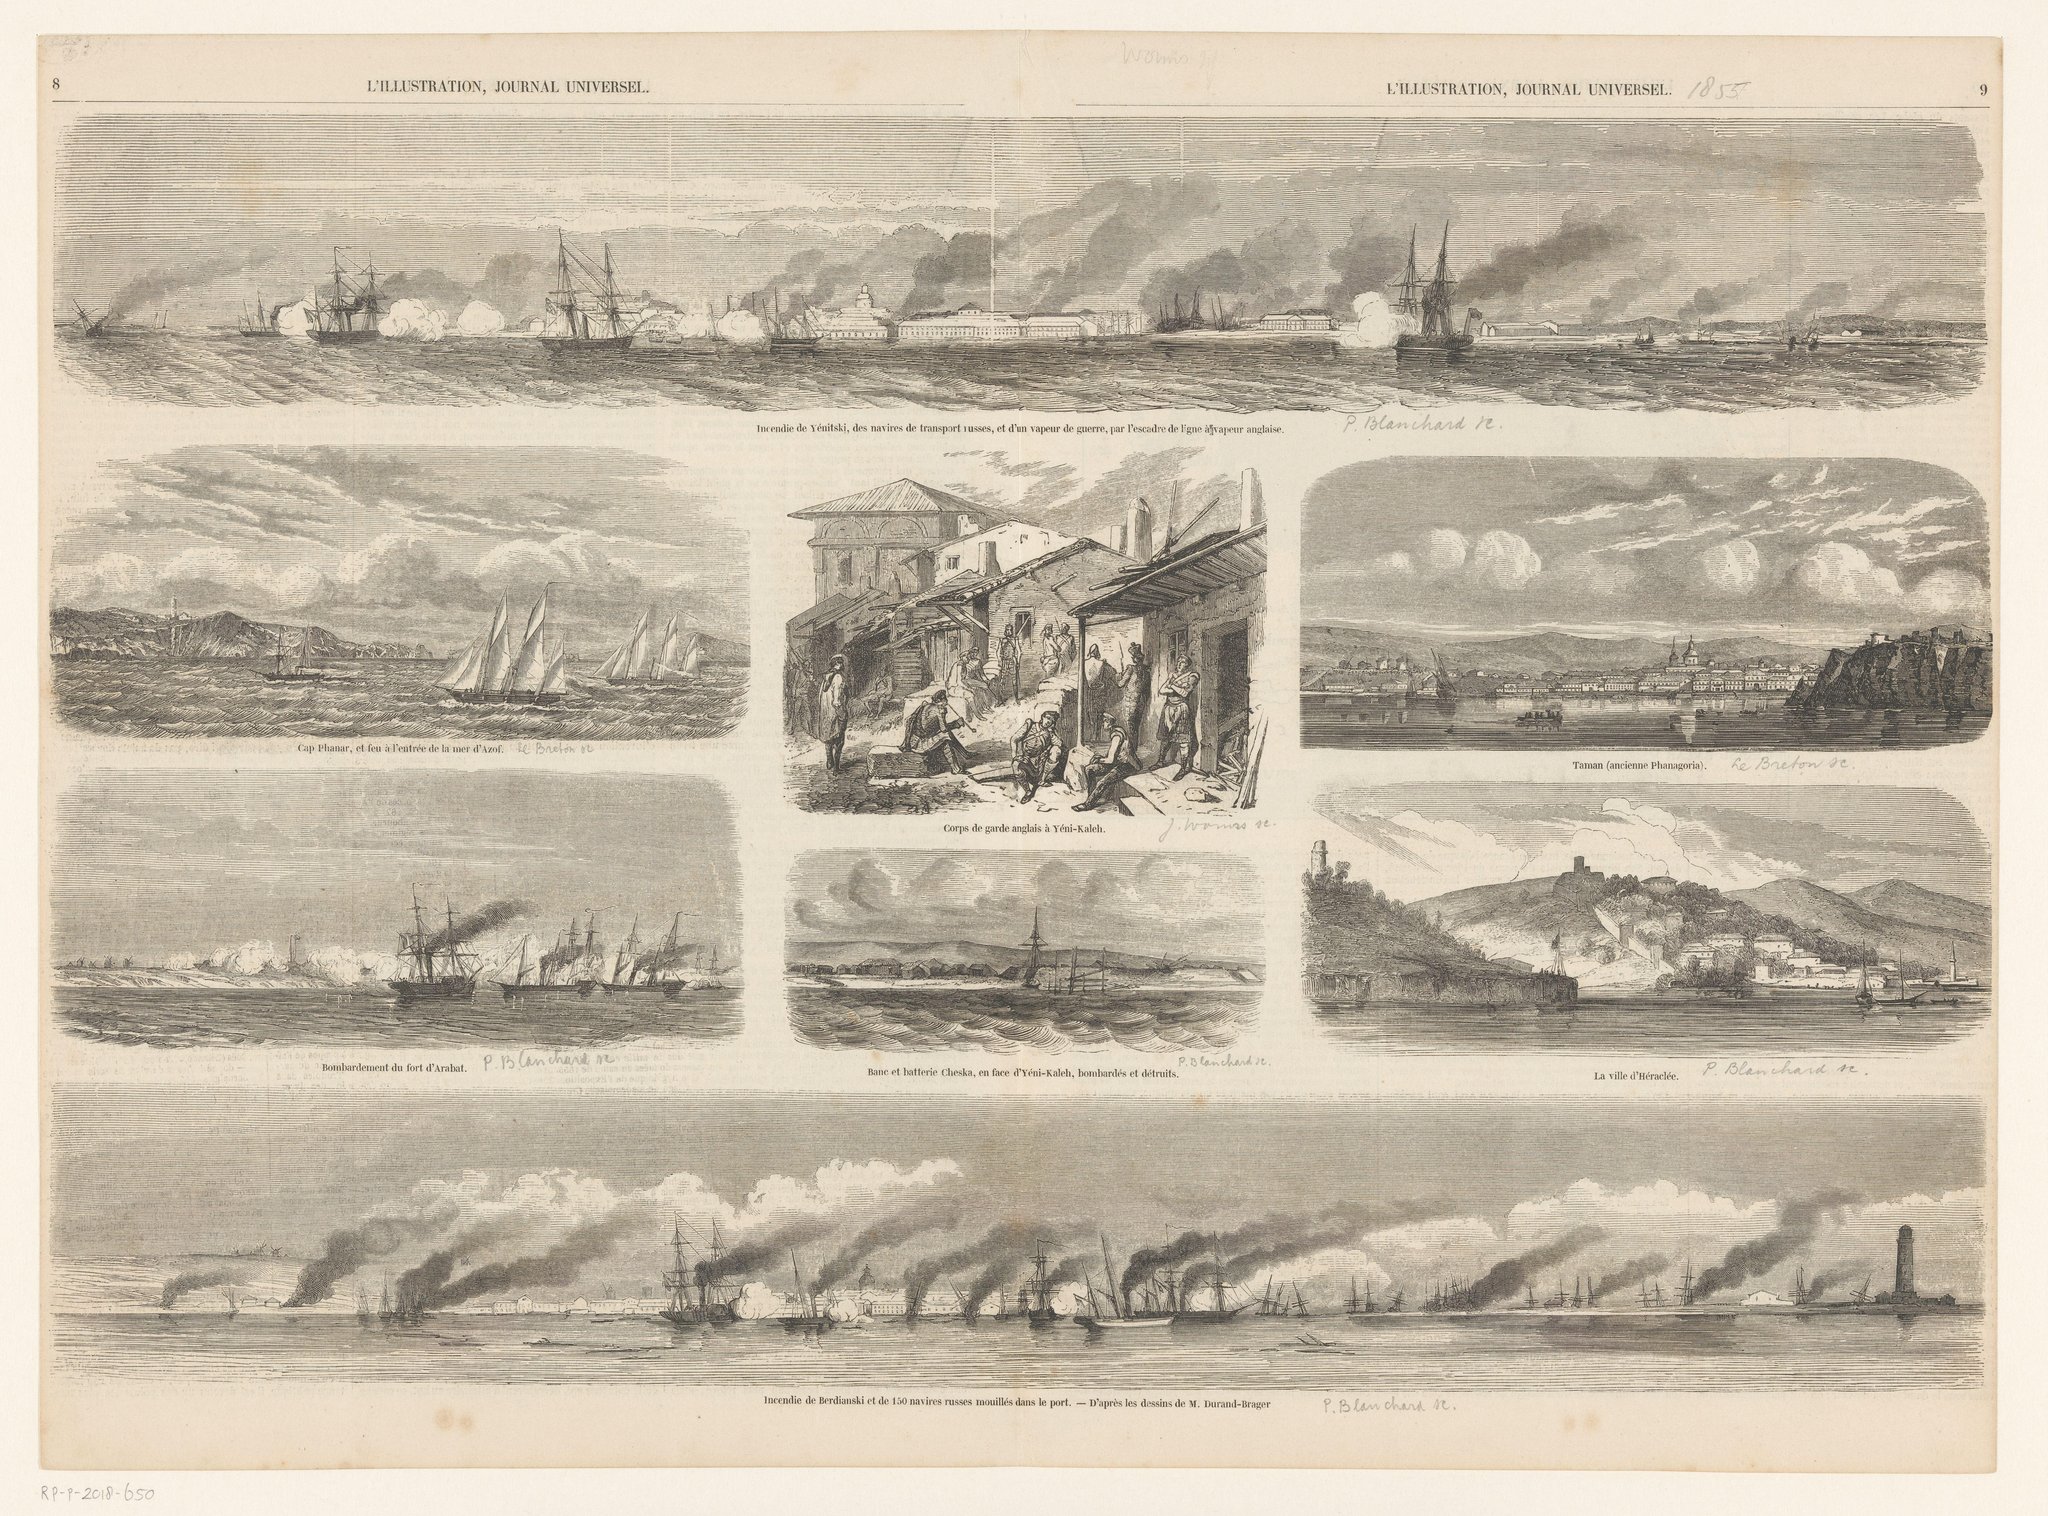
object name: book illustration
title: Acht scènes uit de Krimoorlog, 1855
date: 1855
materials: paper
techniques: engraving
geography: france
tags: battle (+ naval force)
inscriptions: collector's mark: Lugt 2228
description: Dubbele pagina met acht scènes uit de Krimoorlog, 1855. Merendeels zeeslagen.